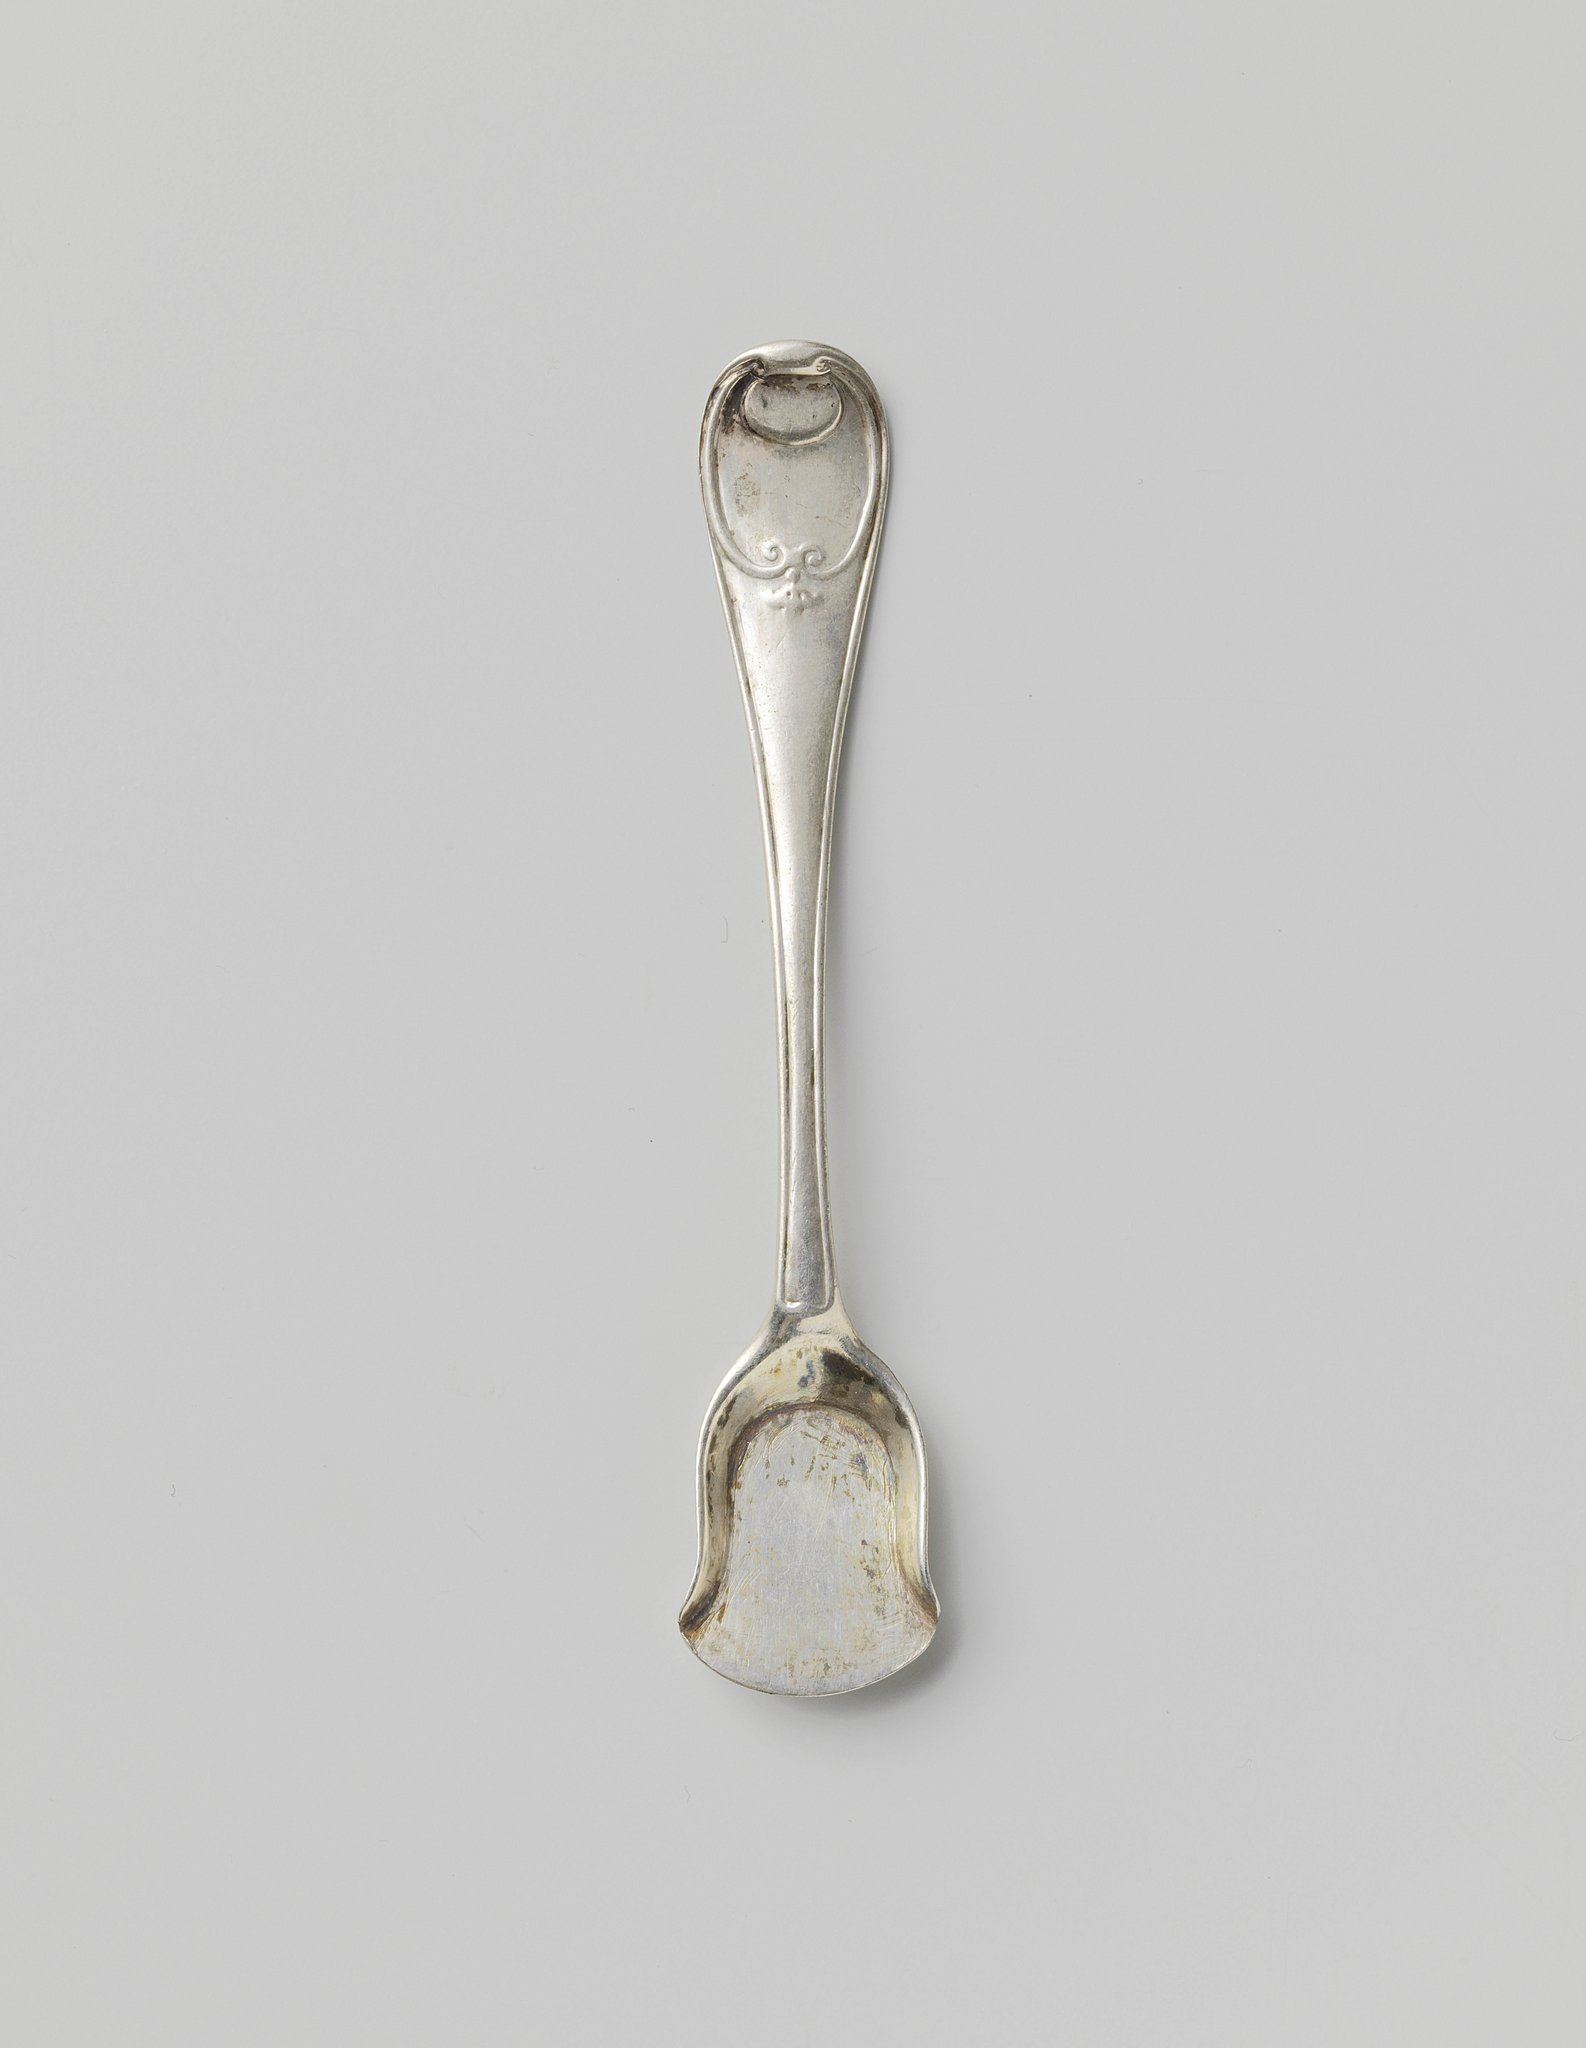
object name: spoon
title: Zoutlepel van zilver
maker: jacob schenk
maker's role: silversmith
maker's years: 1722-1786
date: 1790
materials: silver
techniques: engraving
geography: amsterdam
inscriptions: mark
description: Zoutlepel van zilver, met schepvormige bak. De onderzijde van het uiteinde van de steel is gegraveerd.